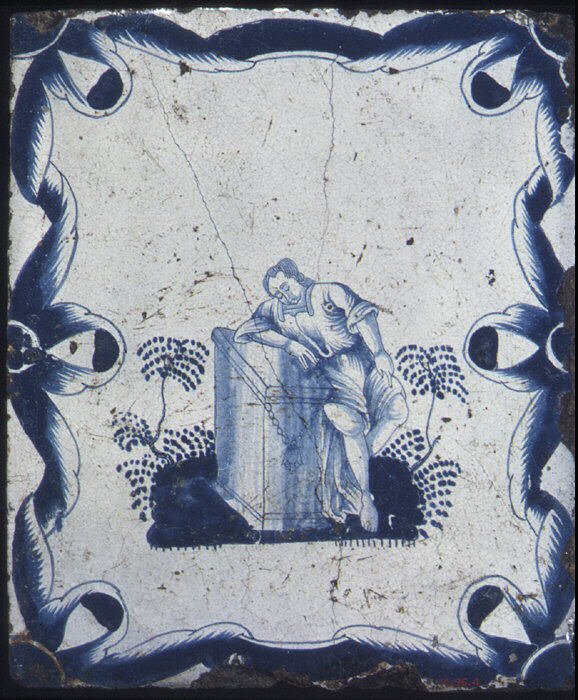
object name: stove tile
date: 1701-1800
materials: pottery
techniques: glazing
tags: men,plants